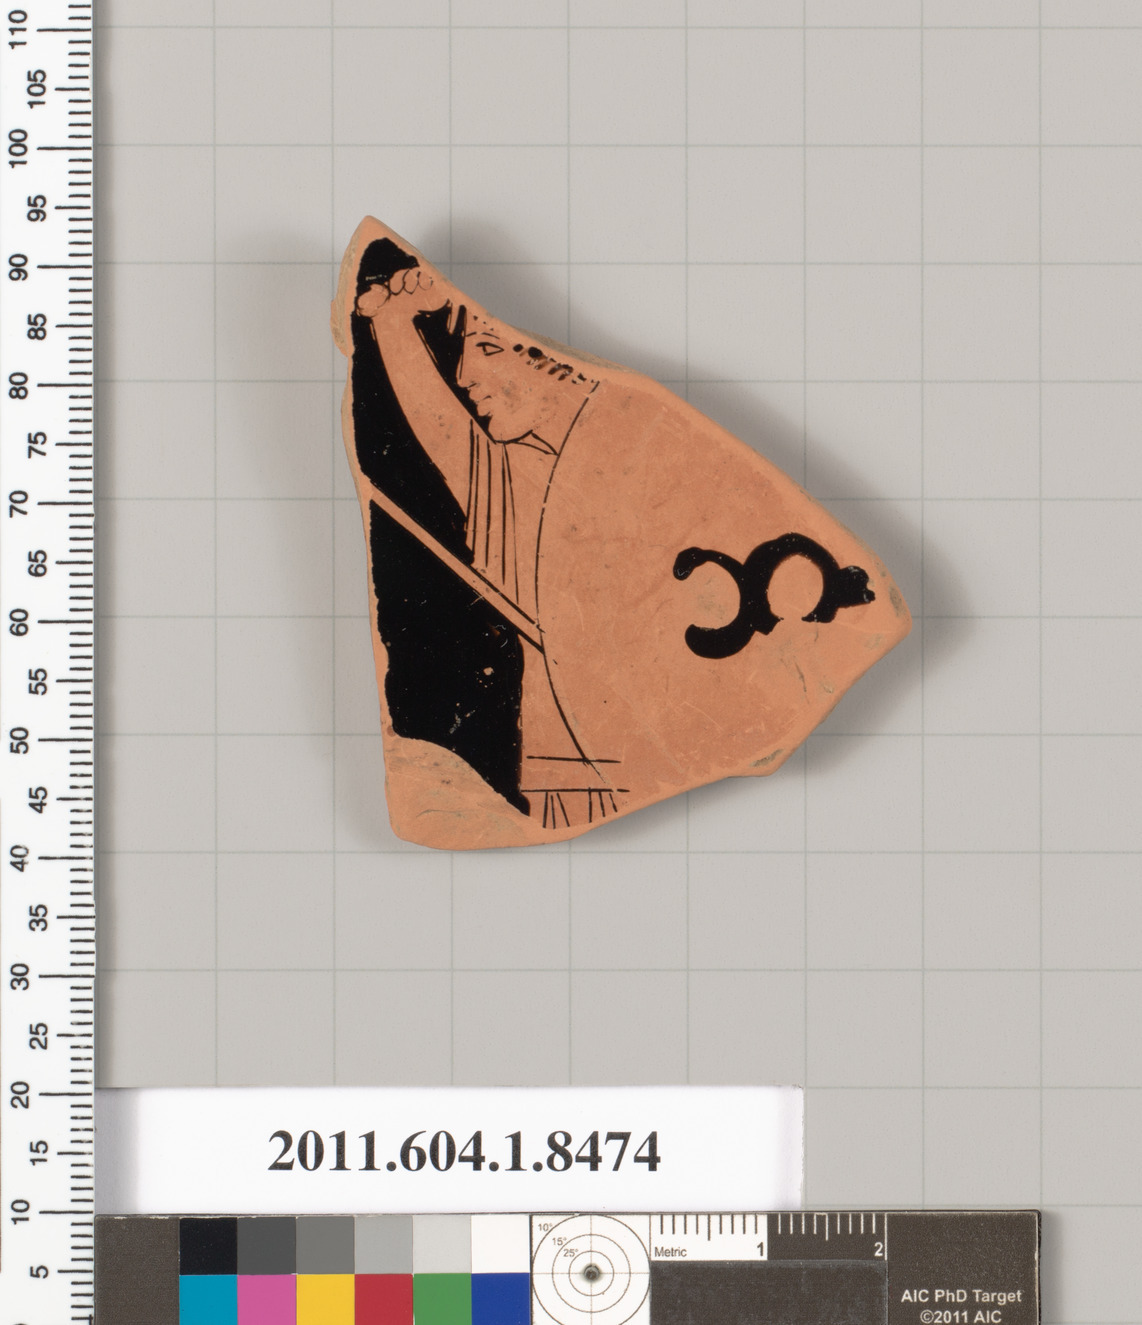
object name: kylix fragment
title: Terracotta fragment of a stemless kylix (drinking cup)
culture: greek, attic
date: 470-450 BCE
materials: terracotta